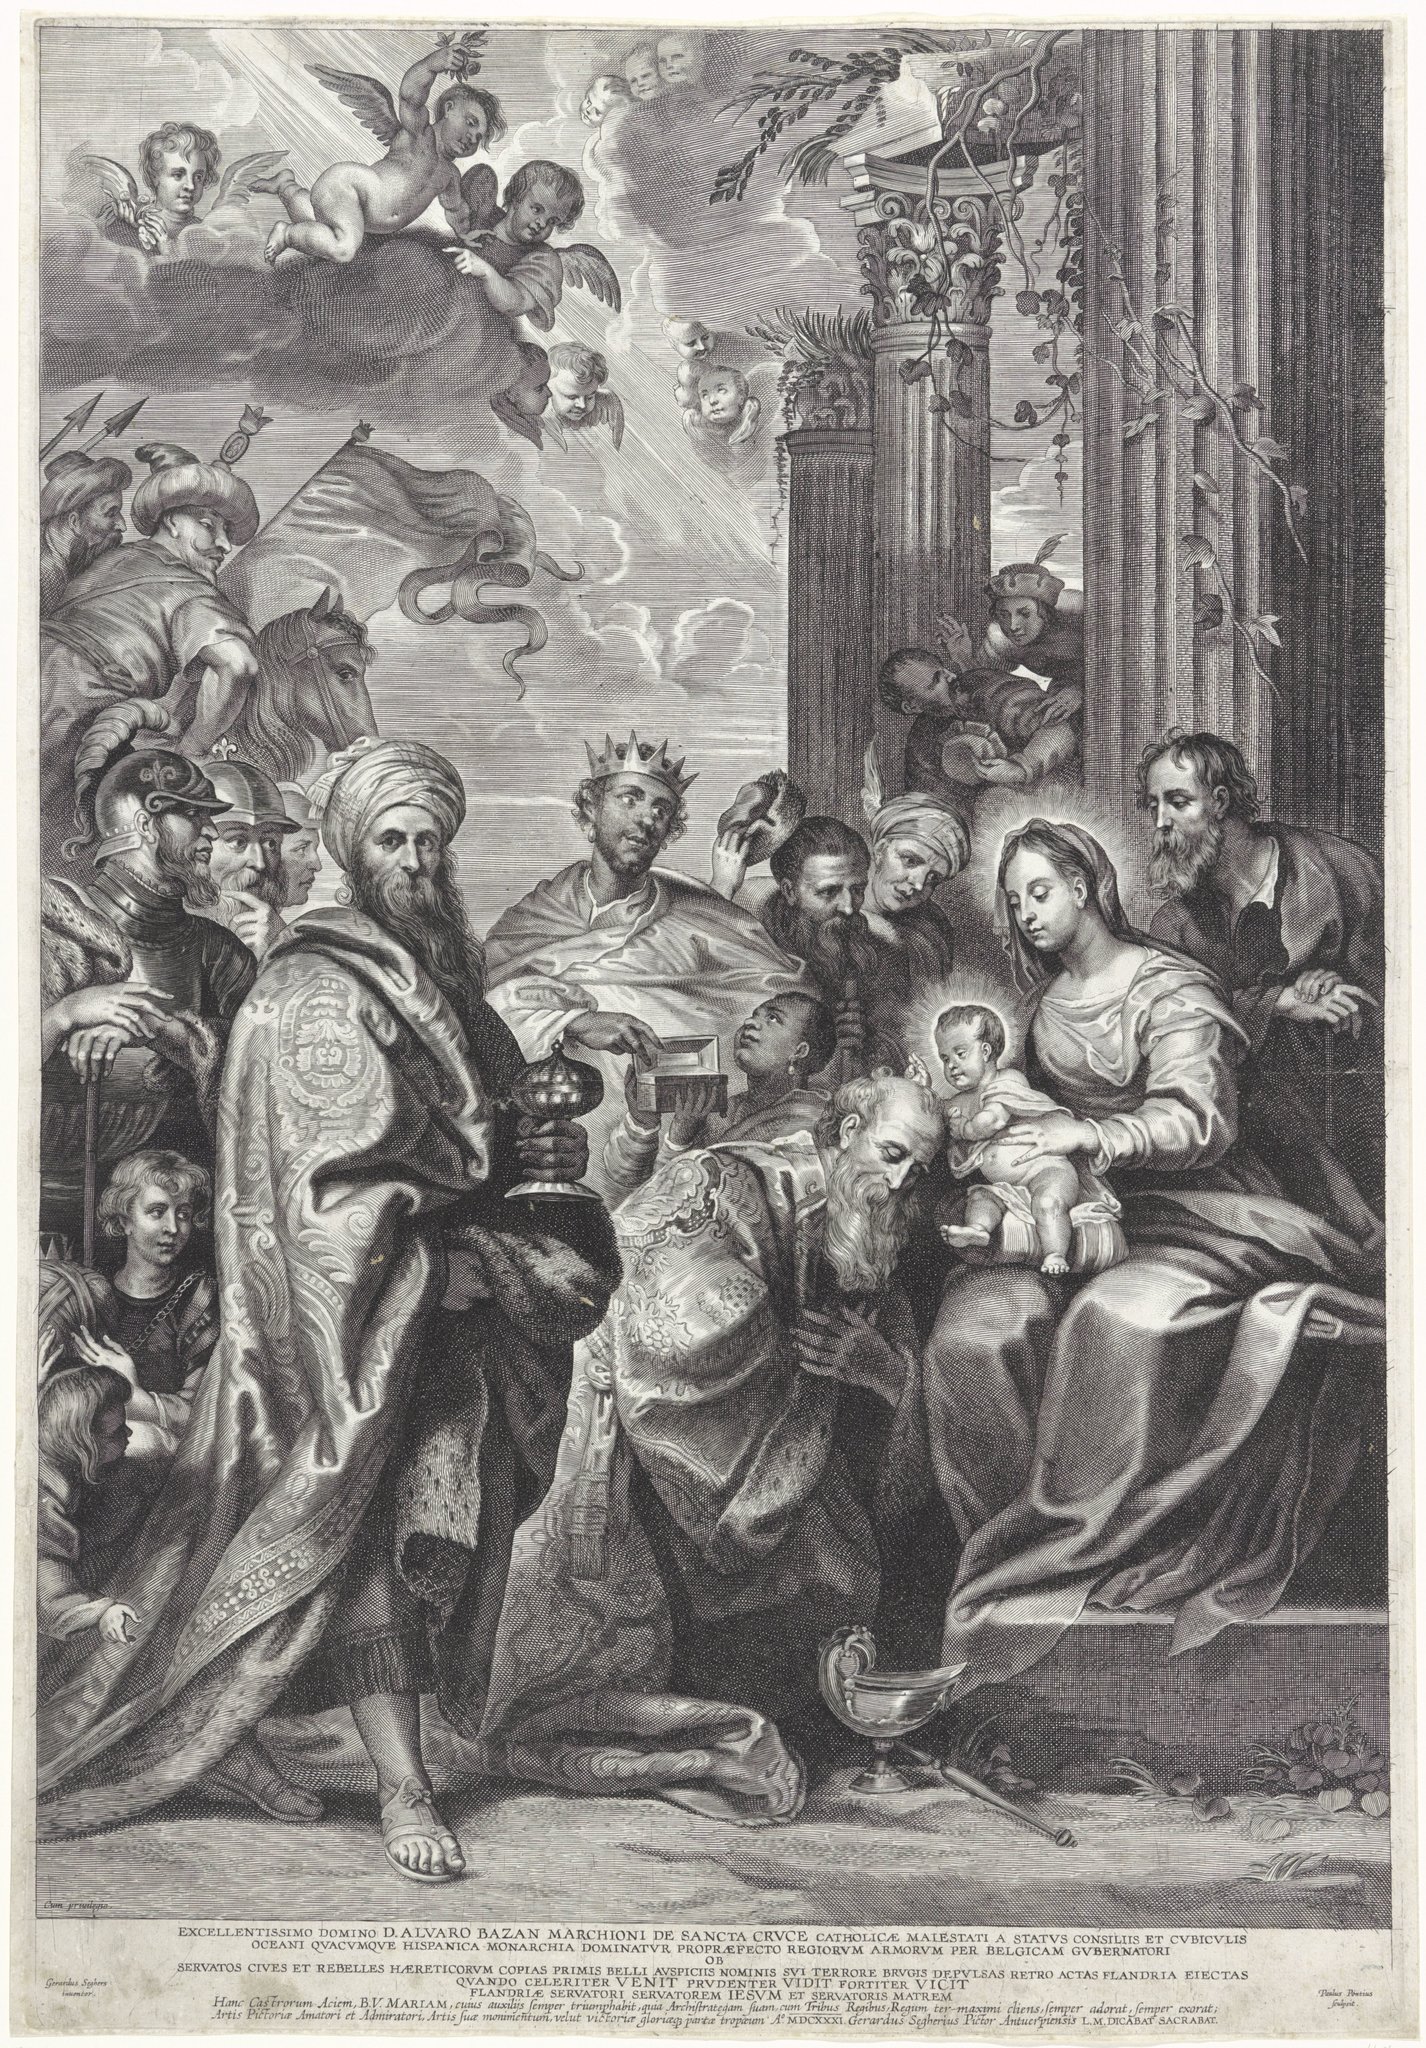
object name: print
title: Aanbidding door de koningen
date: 1631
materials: paper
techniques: engraving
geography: antwerp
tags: adoration of the kings: the wise men present their gifts to the christ-child (gold, frankincense and myrrh)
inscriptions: collector's mark: Lugt 240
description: Het Christuskind, bij Maria op schoot, wordt aanbeden door de drie Wijzen uit het Oosten die zich met hun geschenken voor het Kind hebben opgesteld. Op de achtergrond leden van hun gevolg. Eén van hen knielt voor het Christuskind en ontvangt diens zegening. In de wolken cherubijnen en engeltjes. In de marge een opdracht in het Latijn.